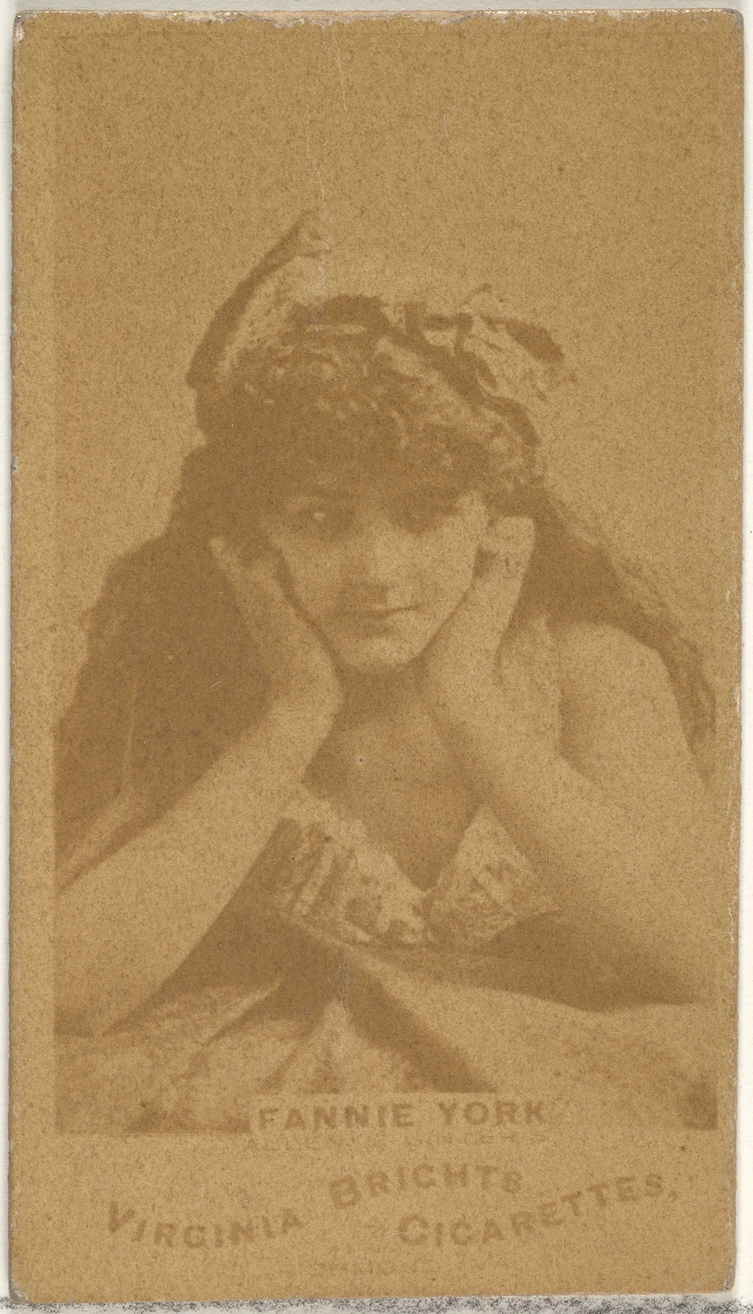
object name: photograph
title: Fannie York, from the Actors and Actresses series (N45, Type 1) for Virginia Brights Cigarettes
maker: allen & ginter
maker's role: publisher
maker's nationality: american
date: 1888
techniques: albumen silver print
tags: portraits,women,actresses